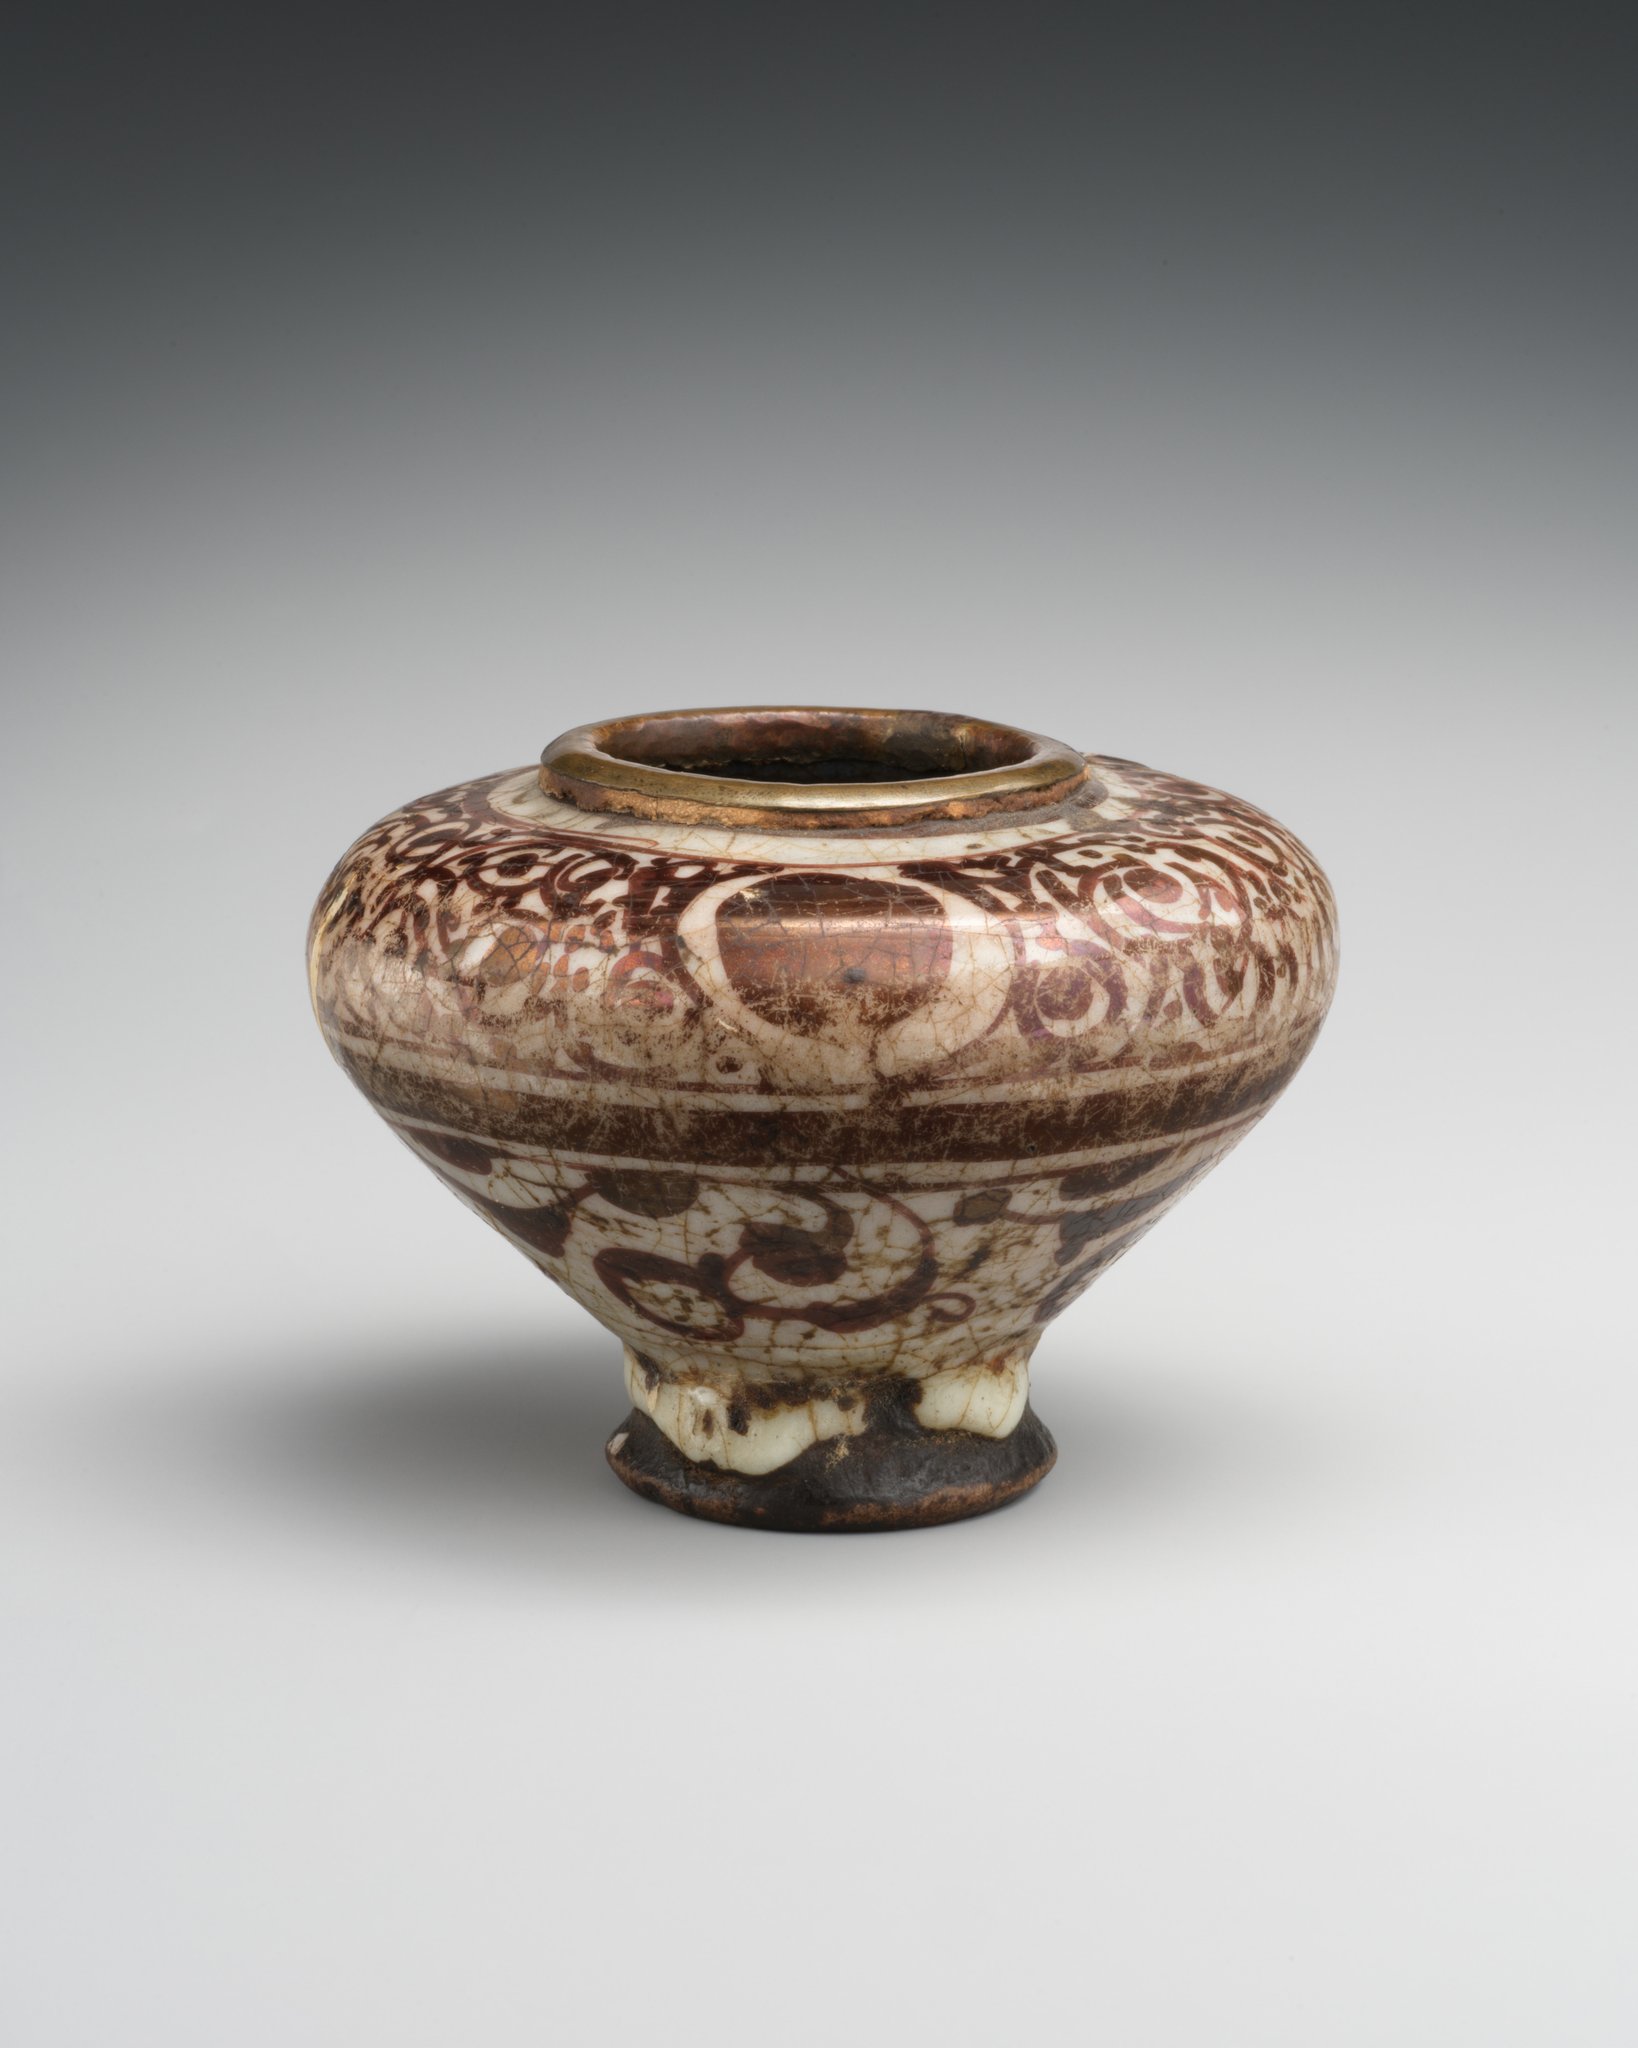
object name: jar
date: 1101-1300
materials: stonepaste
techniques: glazing, luster painting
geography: iran